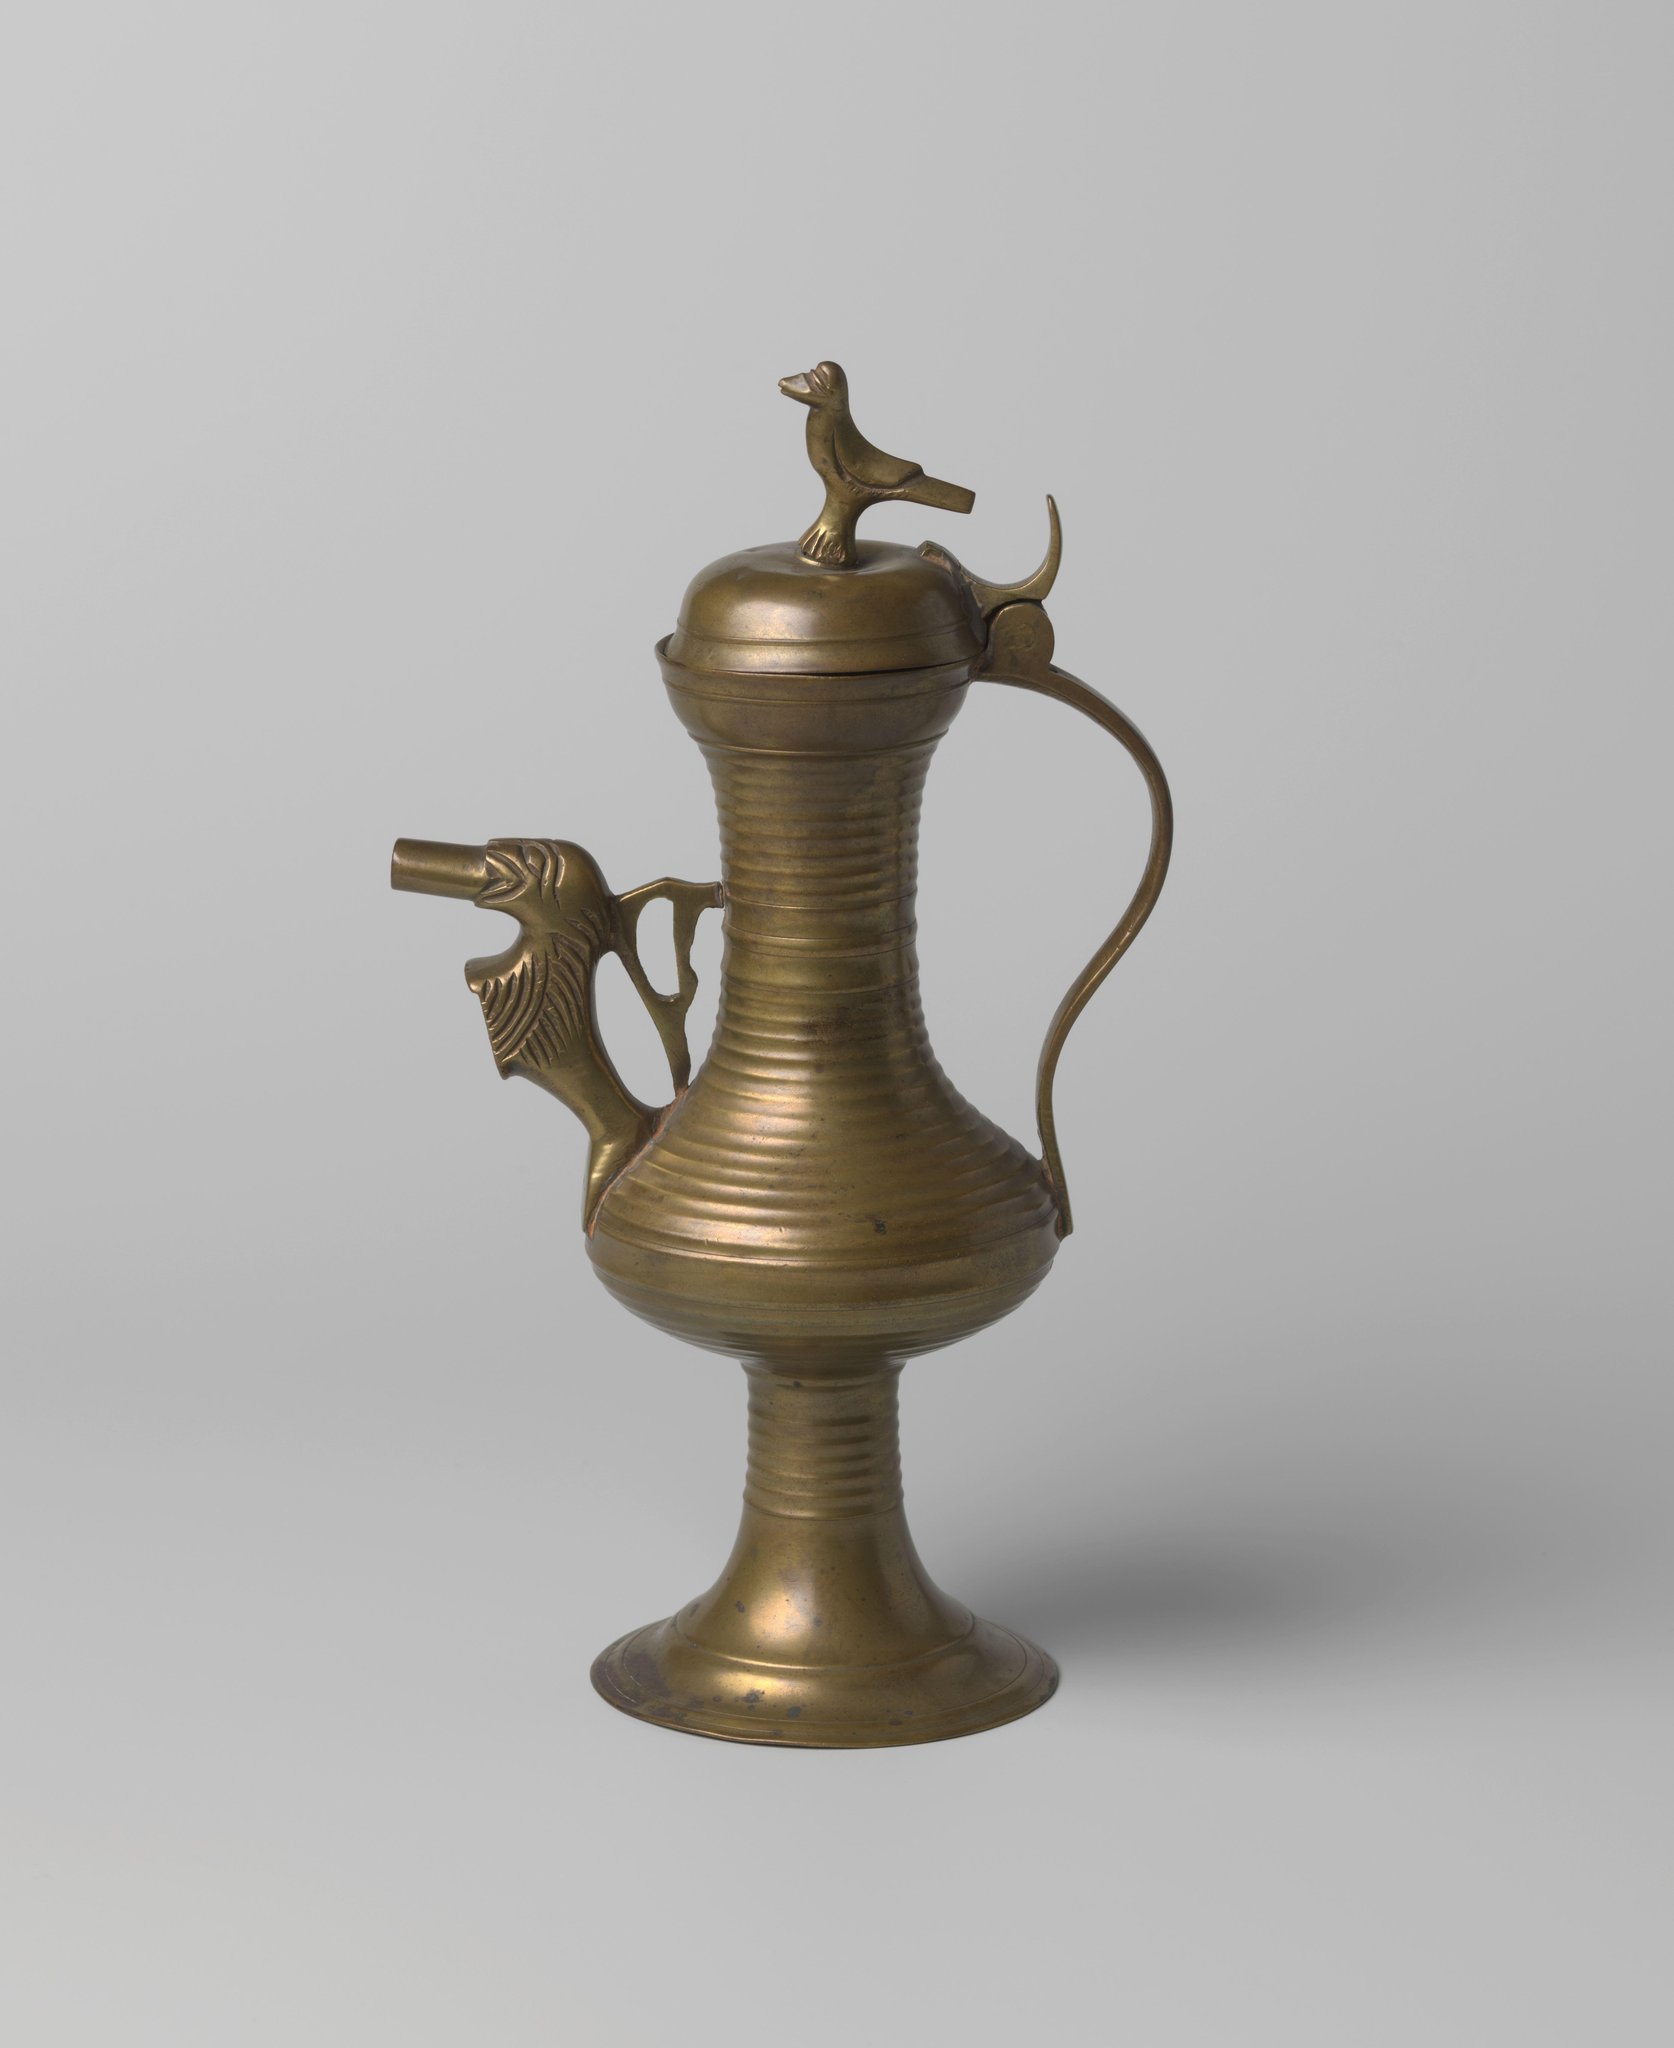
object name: ewer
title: Kan met tuit in de vorm van een leeuw met wapenschild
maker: Anonymous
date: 1475-1525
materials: brass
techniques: brazing, casting, metalworking, turning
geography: nuremberg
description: Jug. Brass. Nüremberg (?), c. 1475 - 1525.